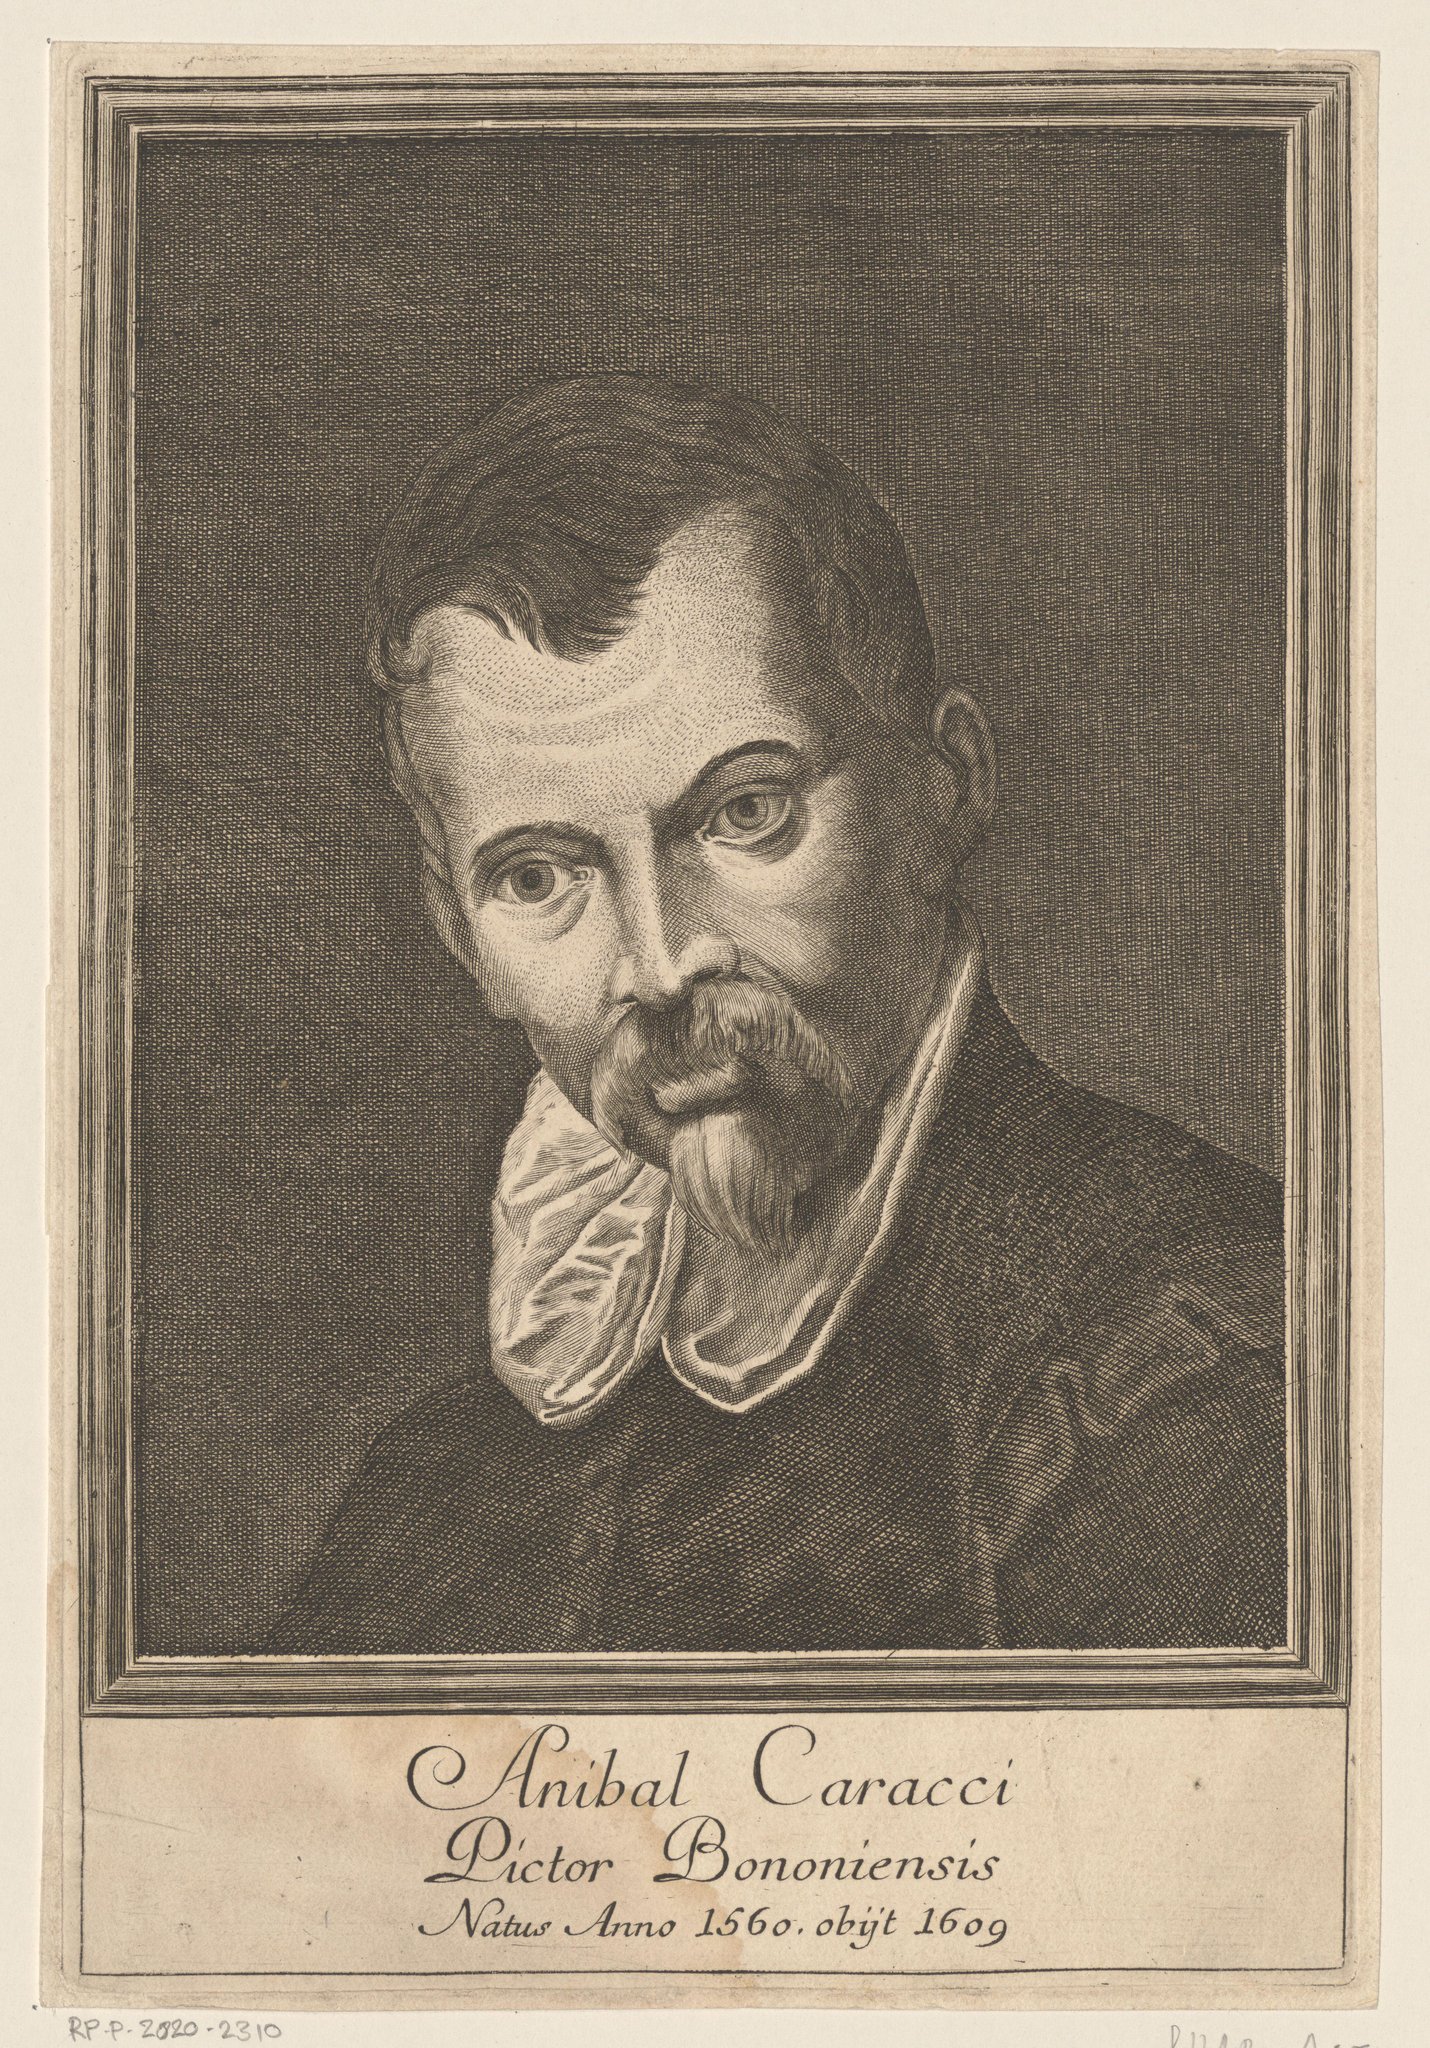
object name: print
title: Portret van Annibale Carracci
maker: Anonymous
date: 1753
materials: paper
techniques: engraving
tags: rome, print maker, draughtsman, annibale carracci, portrait, self-portrait of painter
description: Prent waarschijnlijk uit: Cesi, Carlo. Aedium Farnesiarum Tabulae (...). Rome: Veneziano Monaldini, 1753.